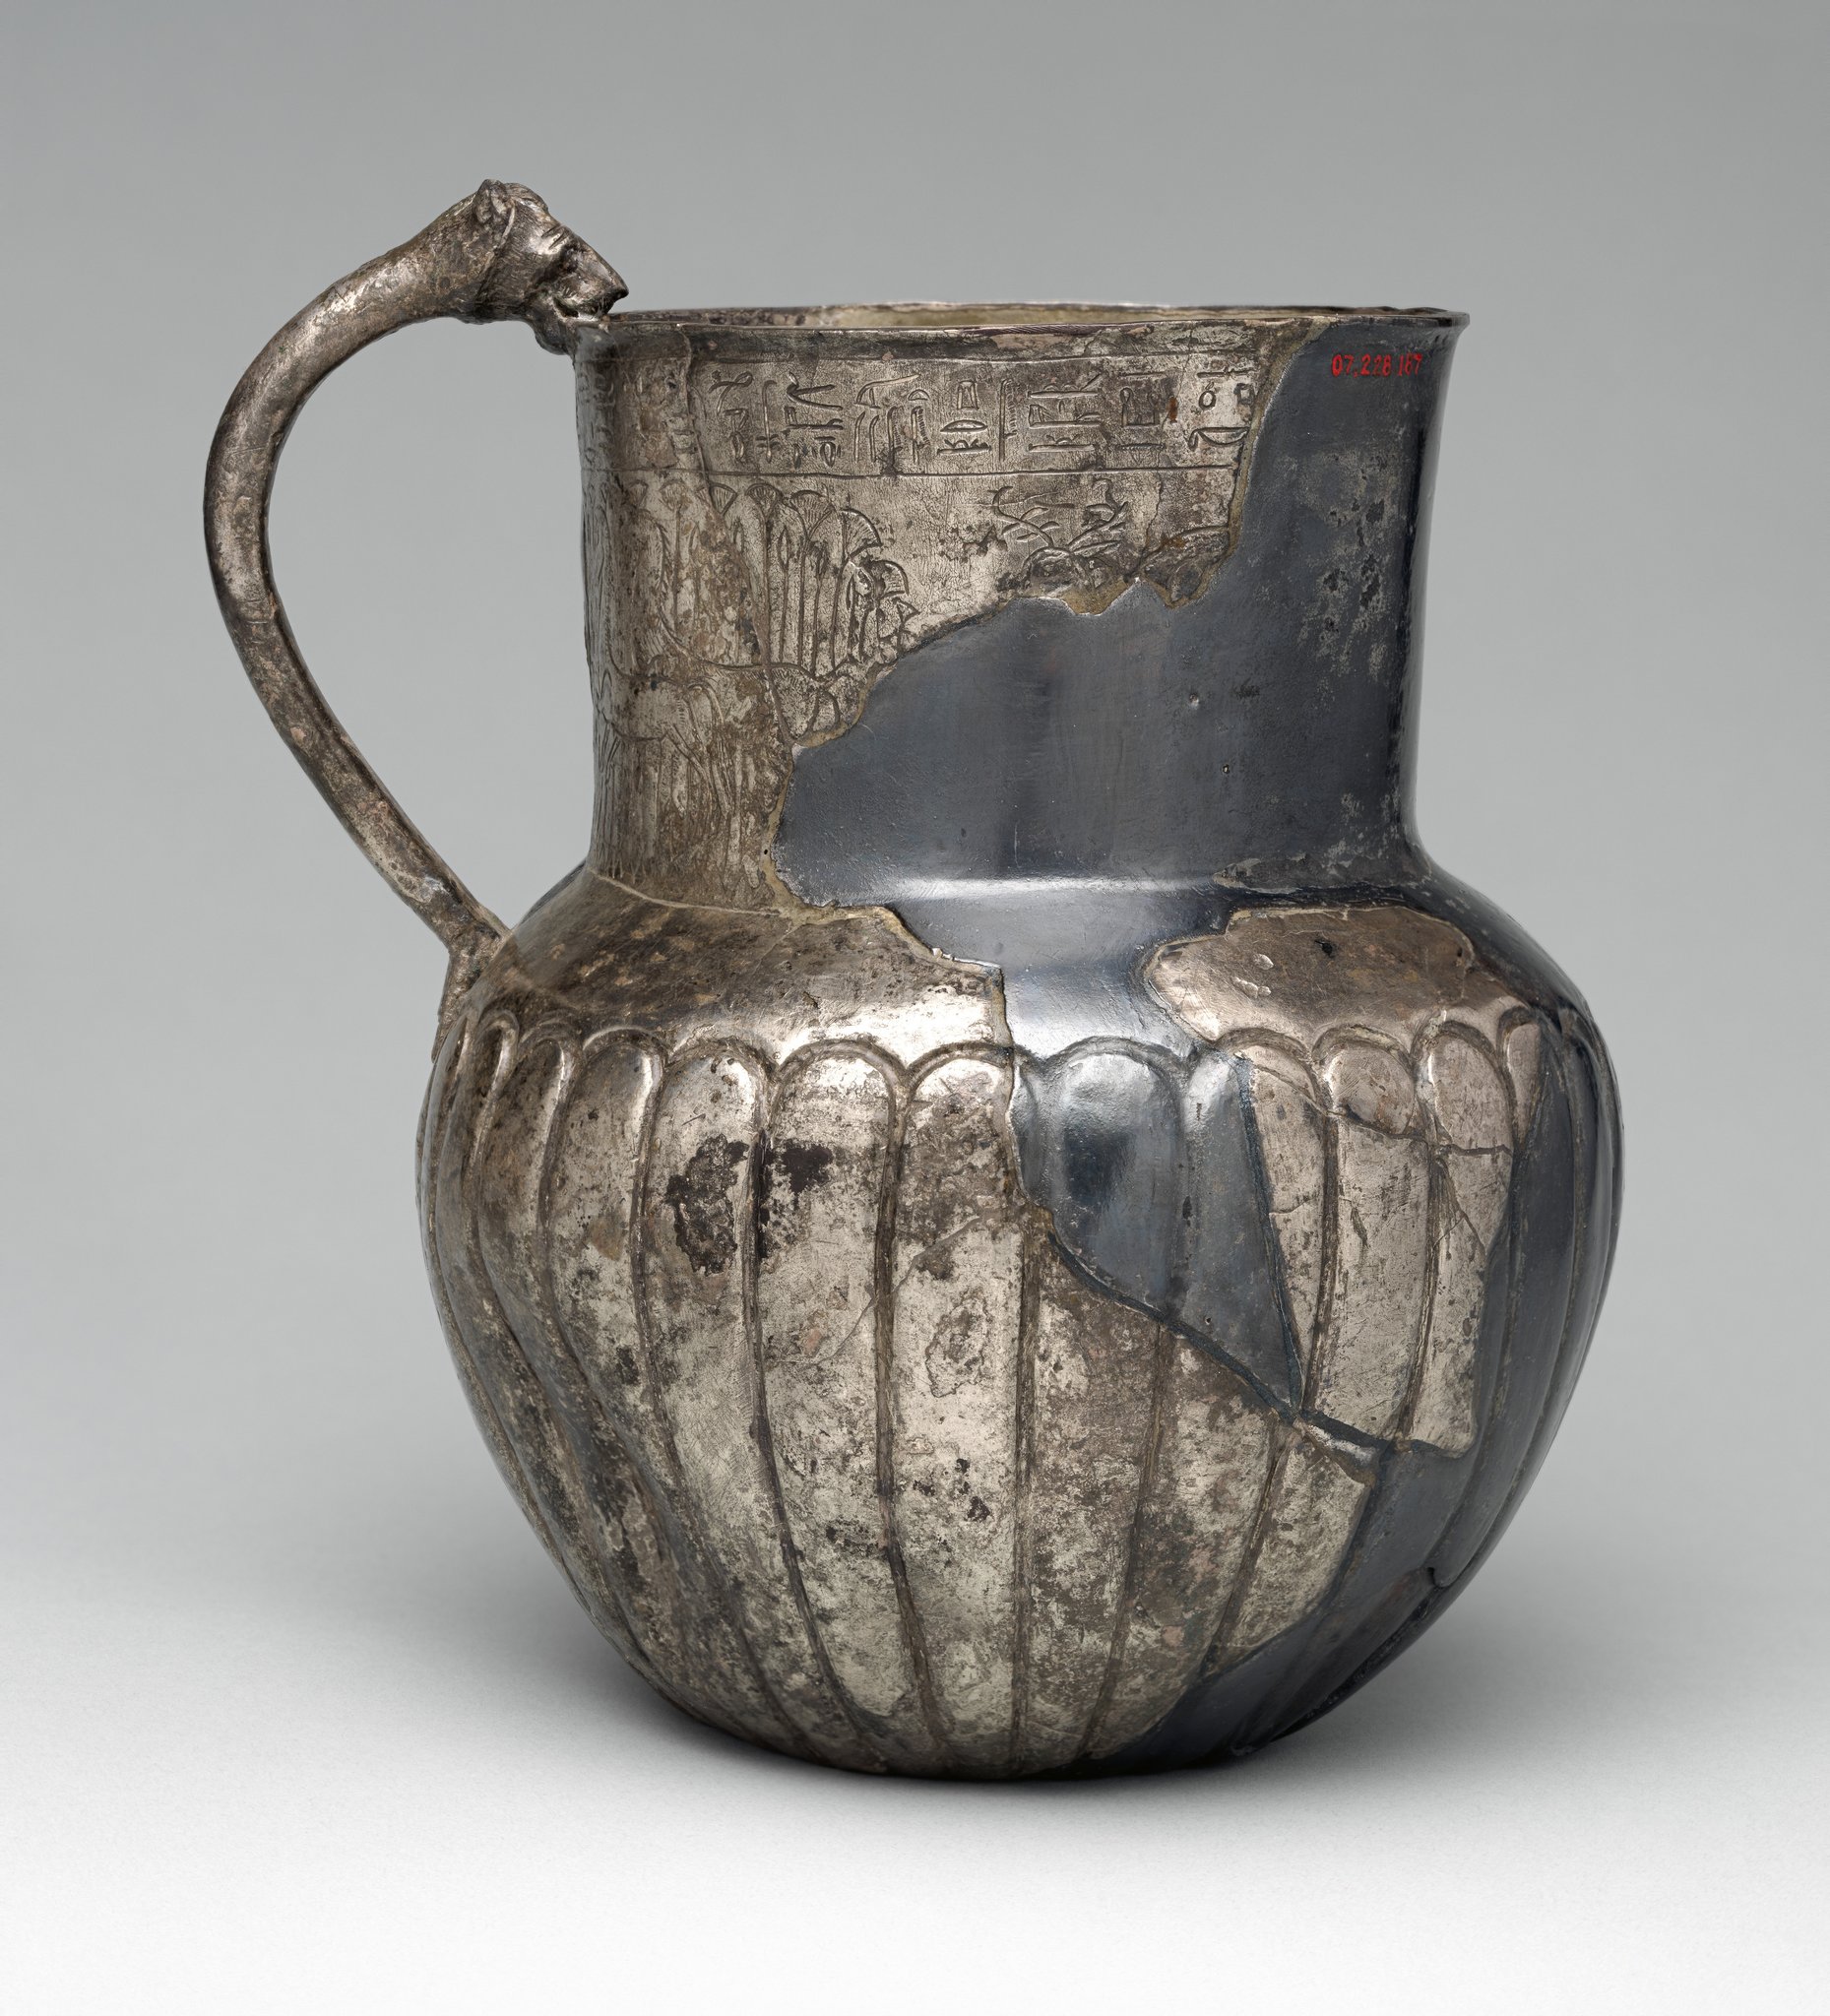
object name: jug, feline head handle, atumemtaneb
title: Decorated Jug with Feline-Head Handle naming Atumemtaneb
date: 1279-1213 BCE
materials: silver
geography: egypt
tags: hieroglyphs